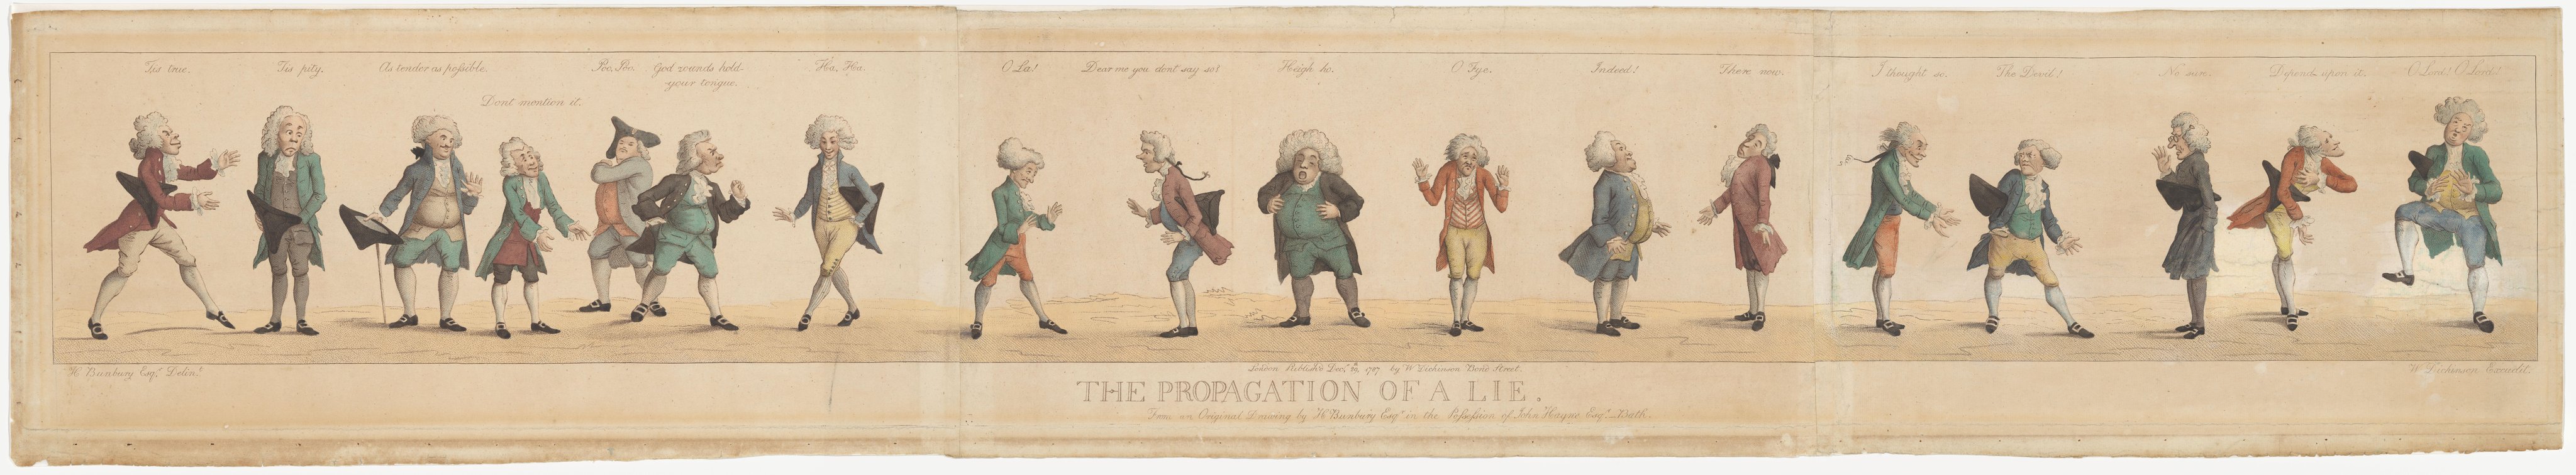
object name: cartoon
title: The Propagation of a Lie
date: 1787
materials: paper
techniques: etching, engraving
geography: london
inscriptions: collector's mark: Lugt 2228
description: Een fries met een opeenvolging van achttien figuren, allemaal mannen. Hun gebaren en uitdrukkingen duiden op plezier, verbazing of afschuw. Boven het hoofd van elke persoon zijn de woorden gegraveerd die hij uitspreekt.